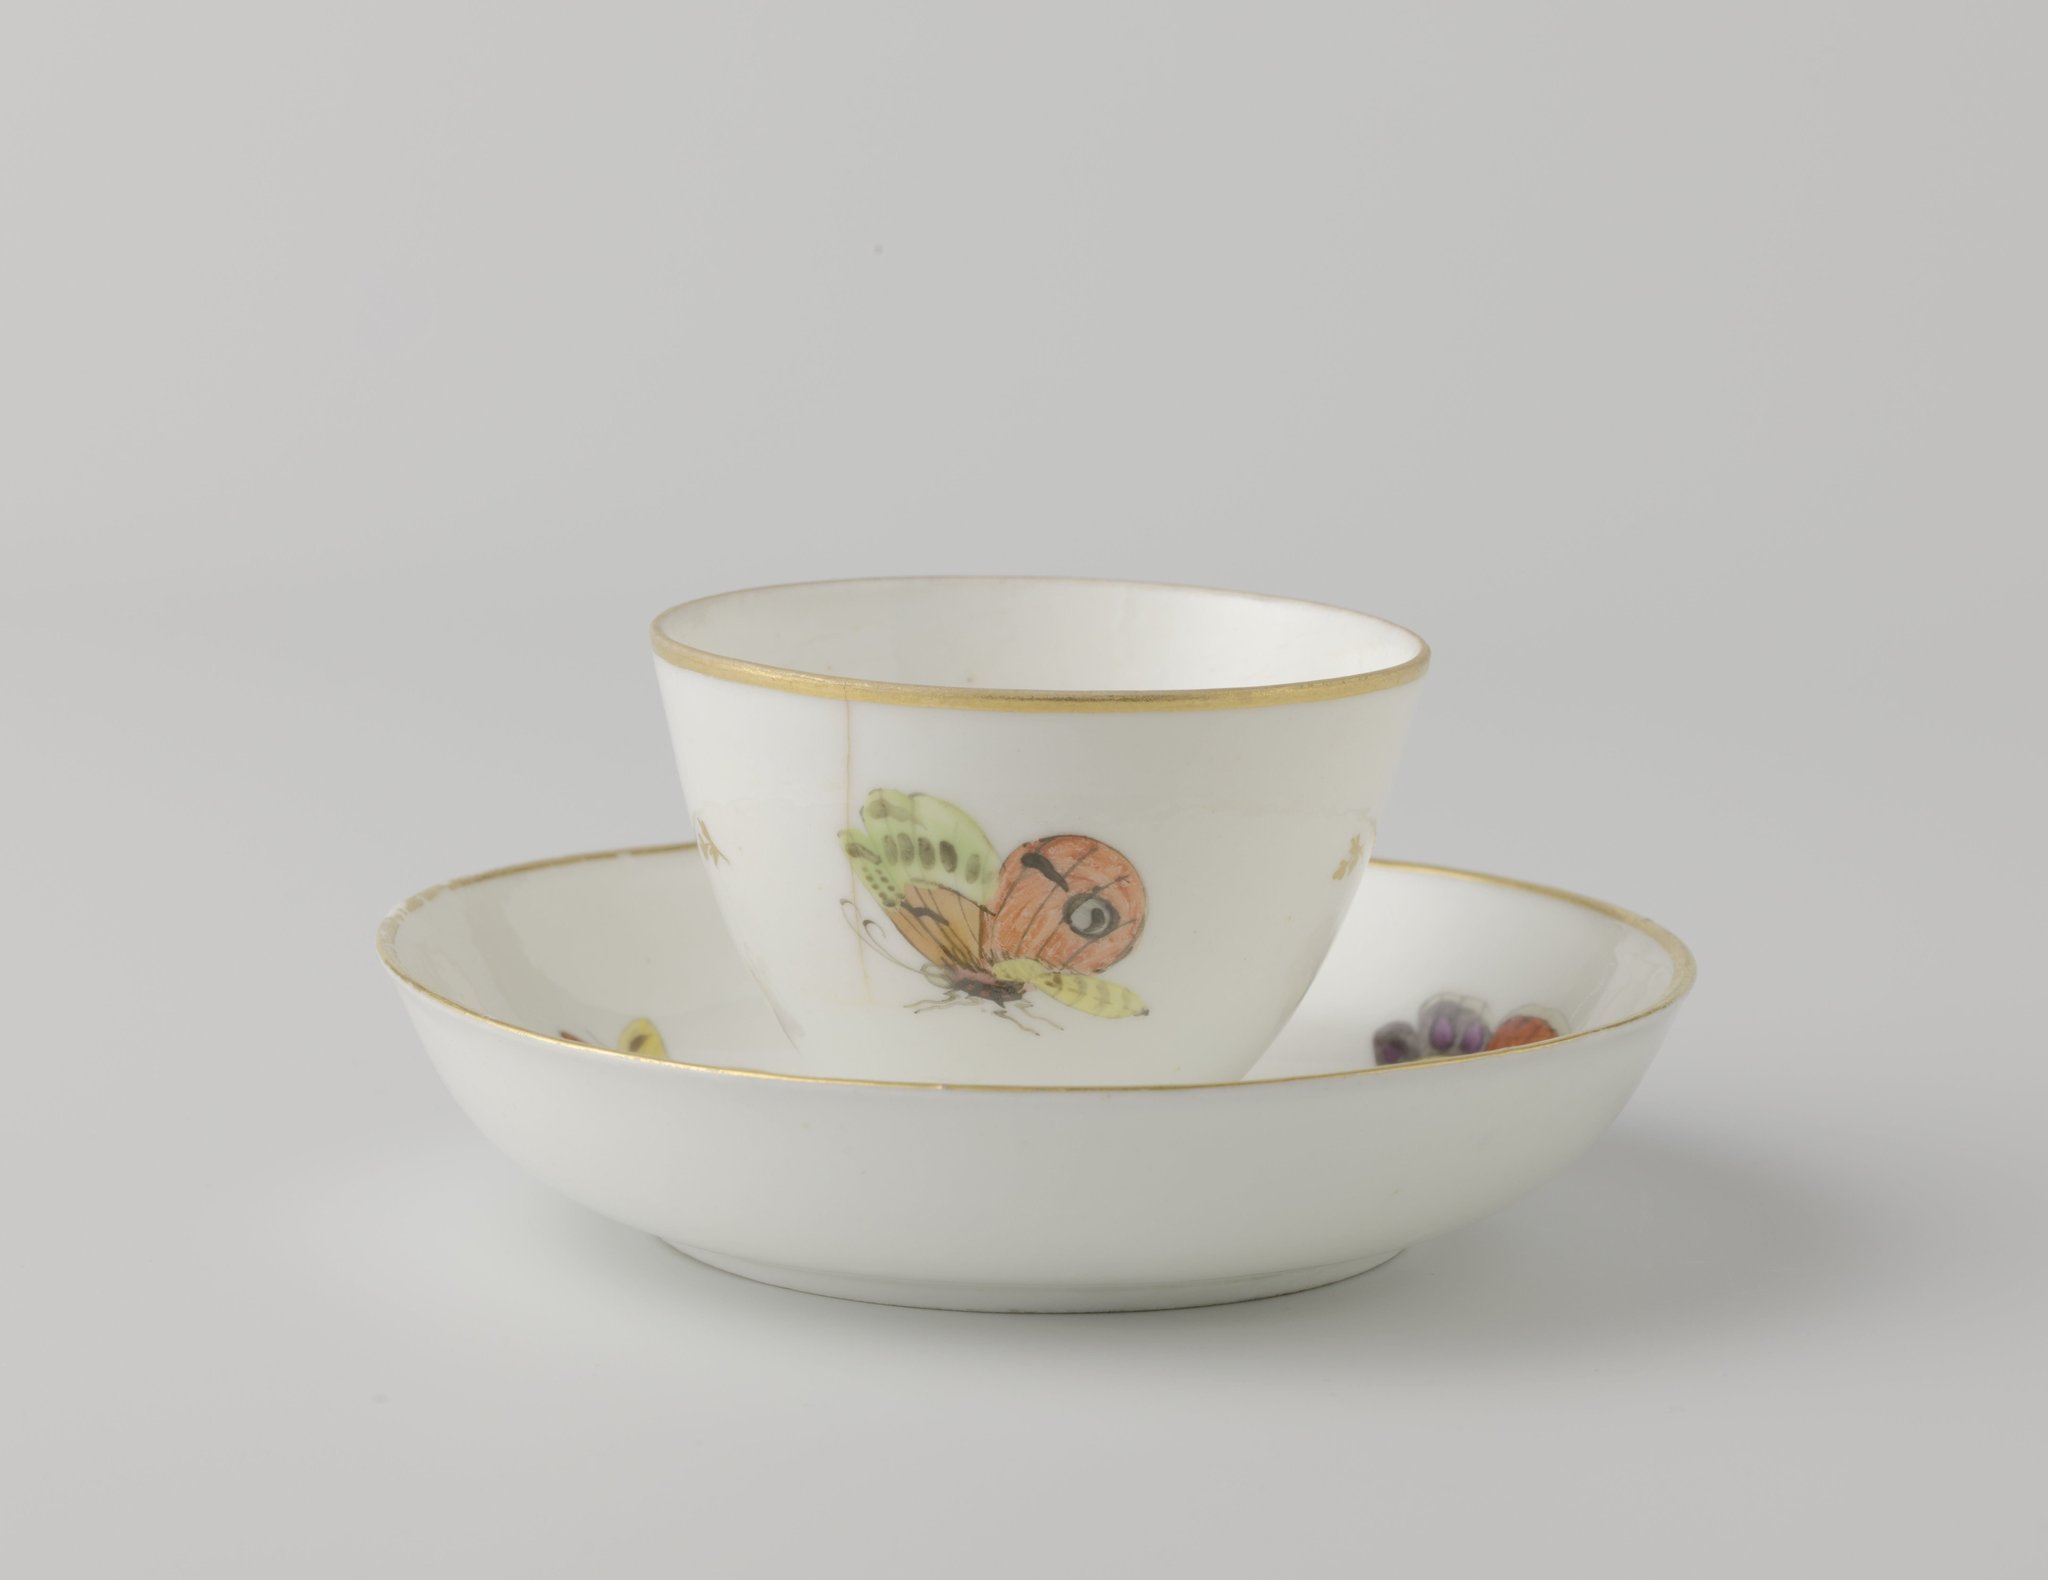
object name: kop en schotel, kop en schotel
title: Kop en schotel beschilderd met vlinders en libellen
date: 1784-1809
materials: porcelain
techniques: painted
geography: ouder-amstel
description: Cup and saucer. Porcelain. Nieuwer-Amstel, c. 1809 - 1814. Factory of Nicolaas Gerard Dommer. Given by Mesdames J.J. and E.S. Kramer, 1942.